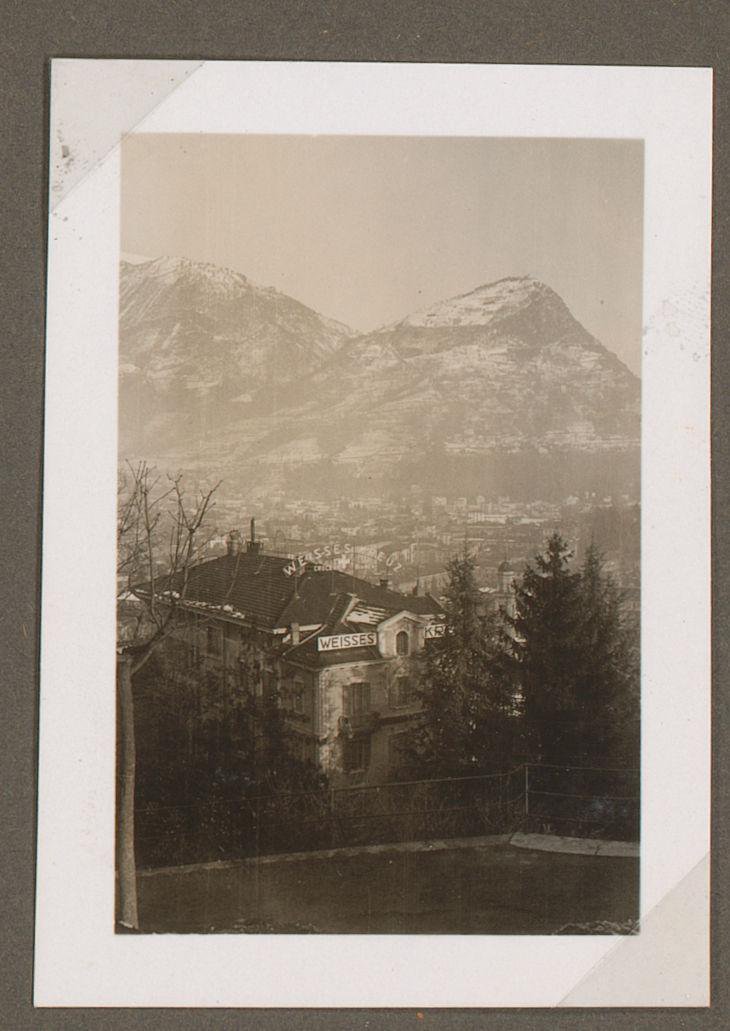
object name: album leaf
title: Lugano vanaf station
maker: Anonymous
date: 1934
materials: photographic support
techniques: gelatin silver print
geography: lugano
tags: dale, valley, city-view in general; 'veduta'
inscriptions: number: ‘31’